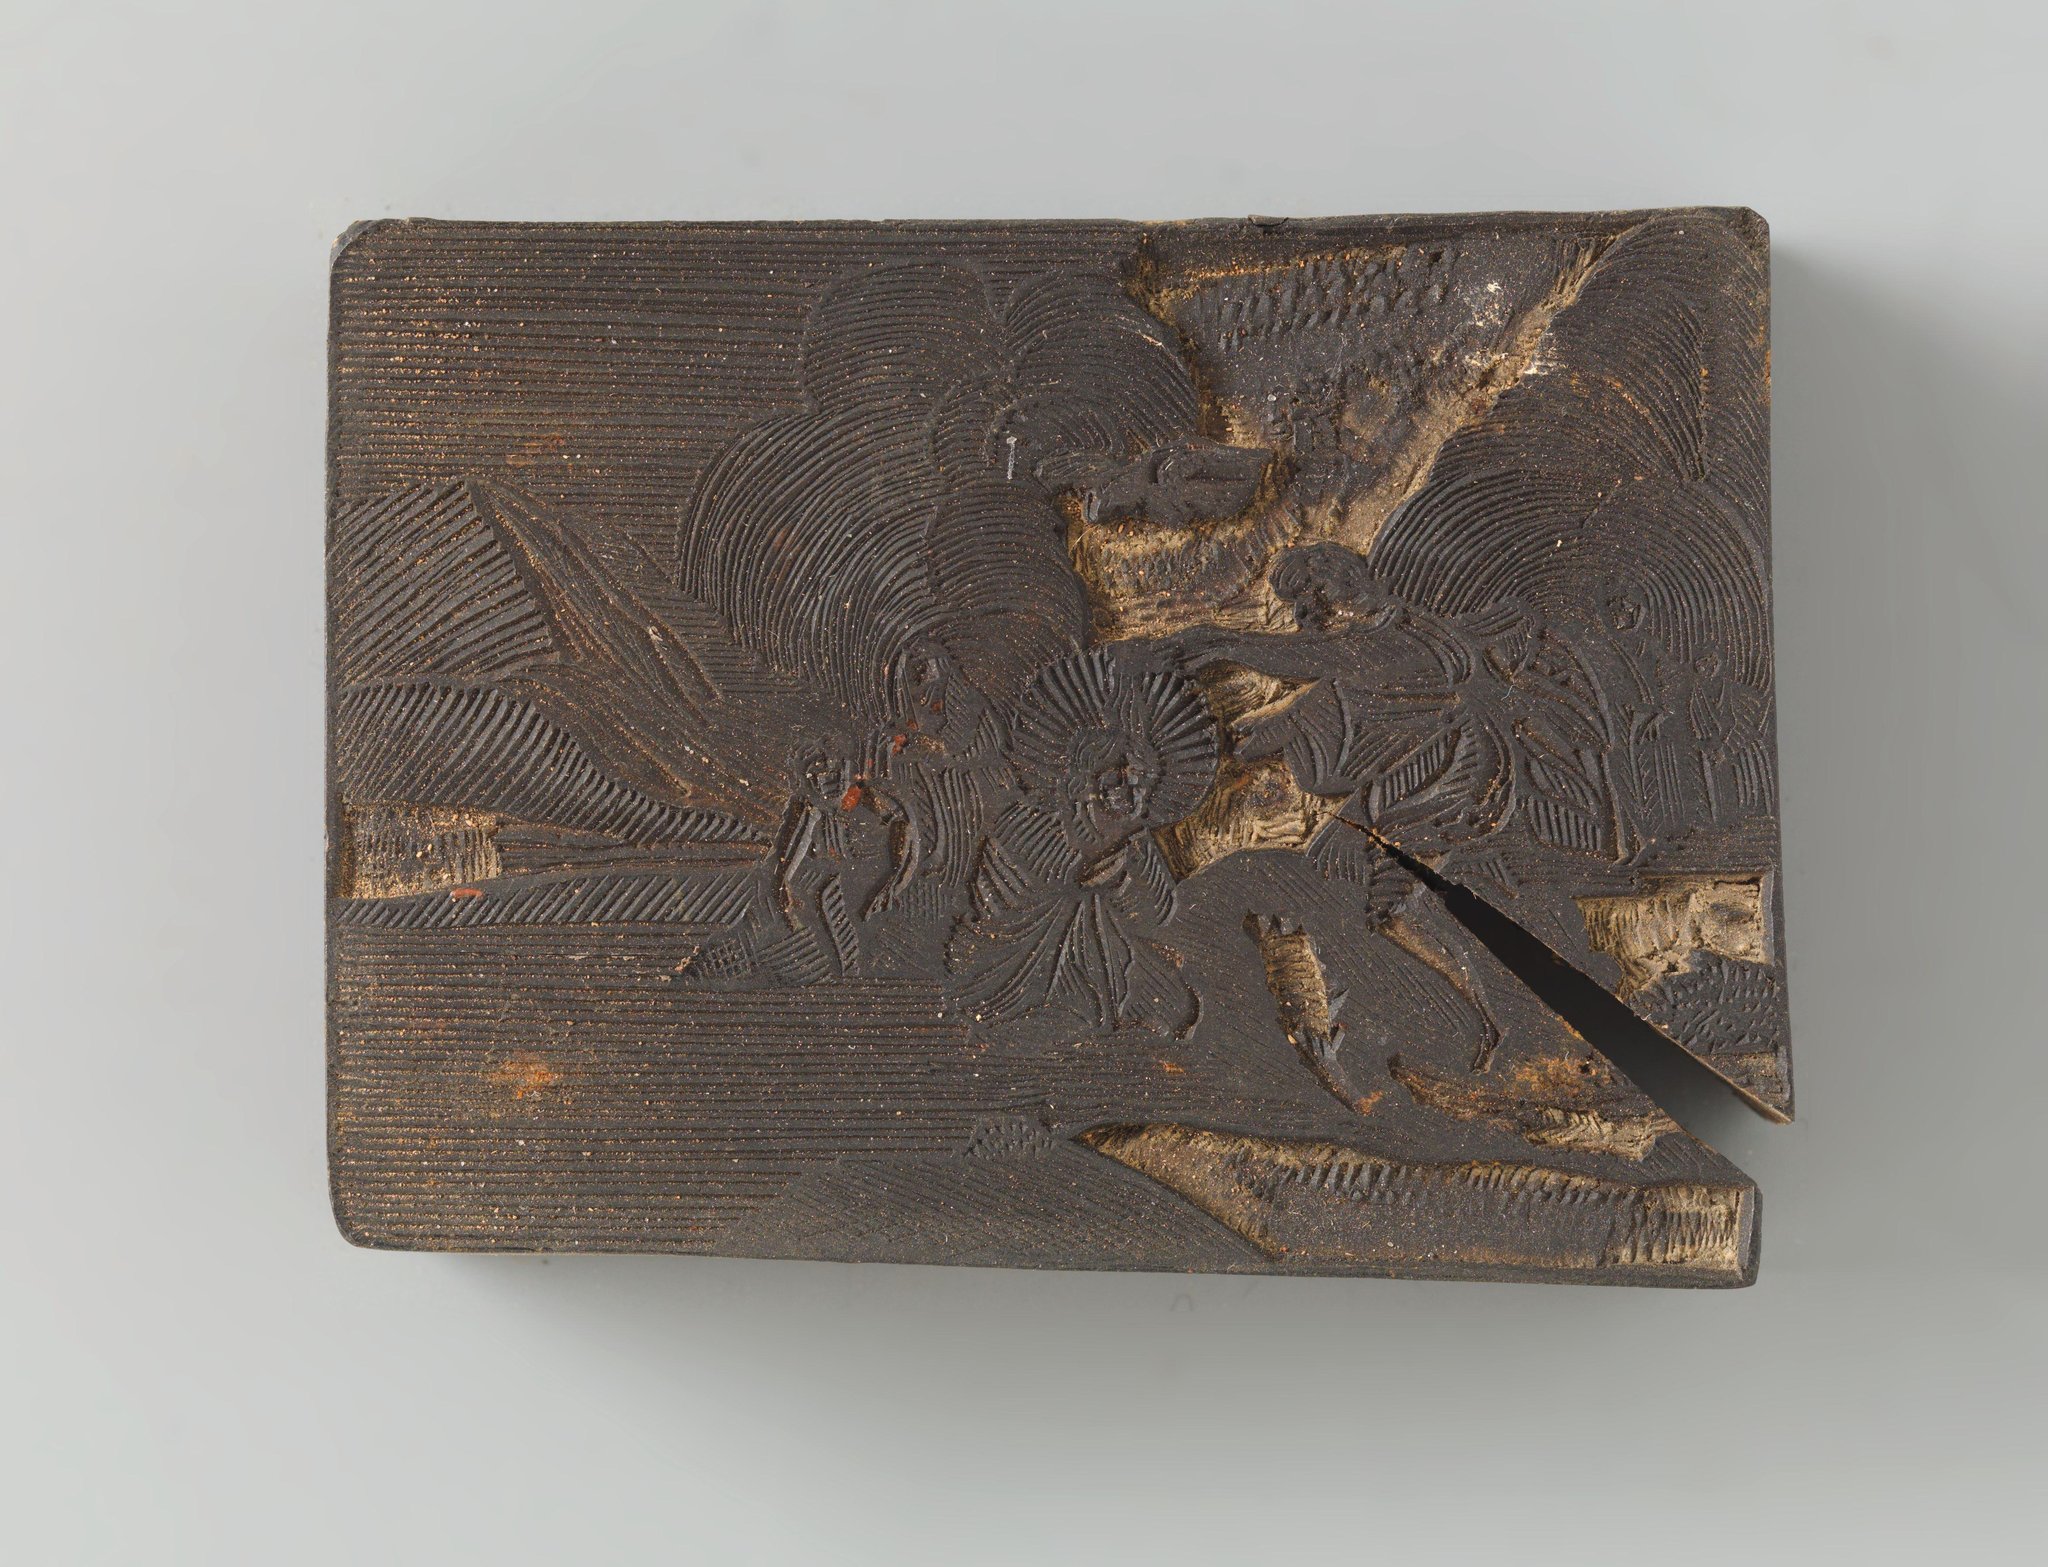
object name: wood block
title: Bijbel-illustraties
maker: Anonymous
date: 1550-1699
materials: wood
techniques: woodcut